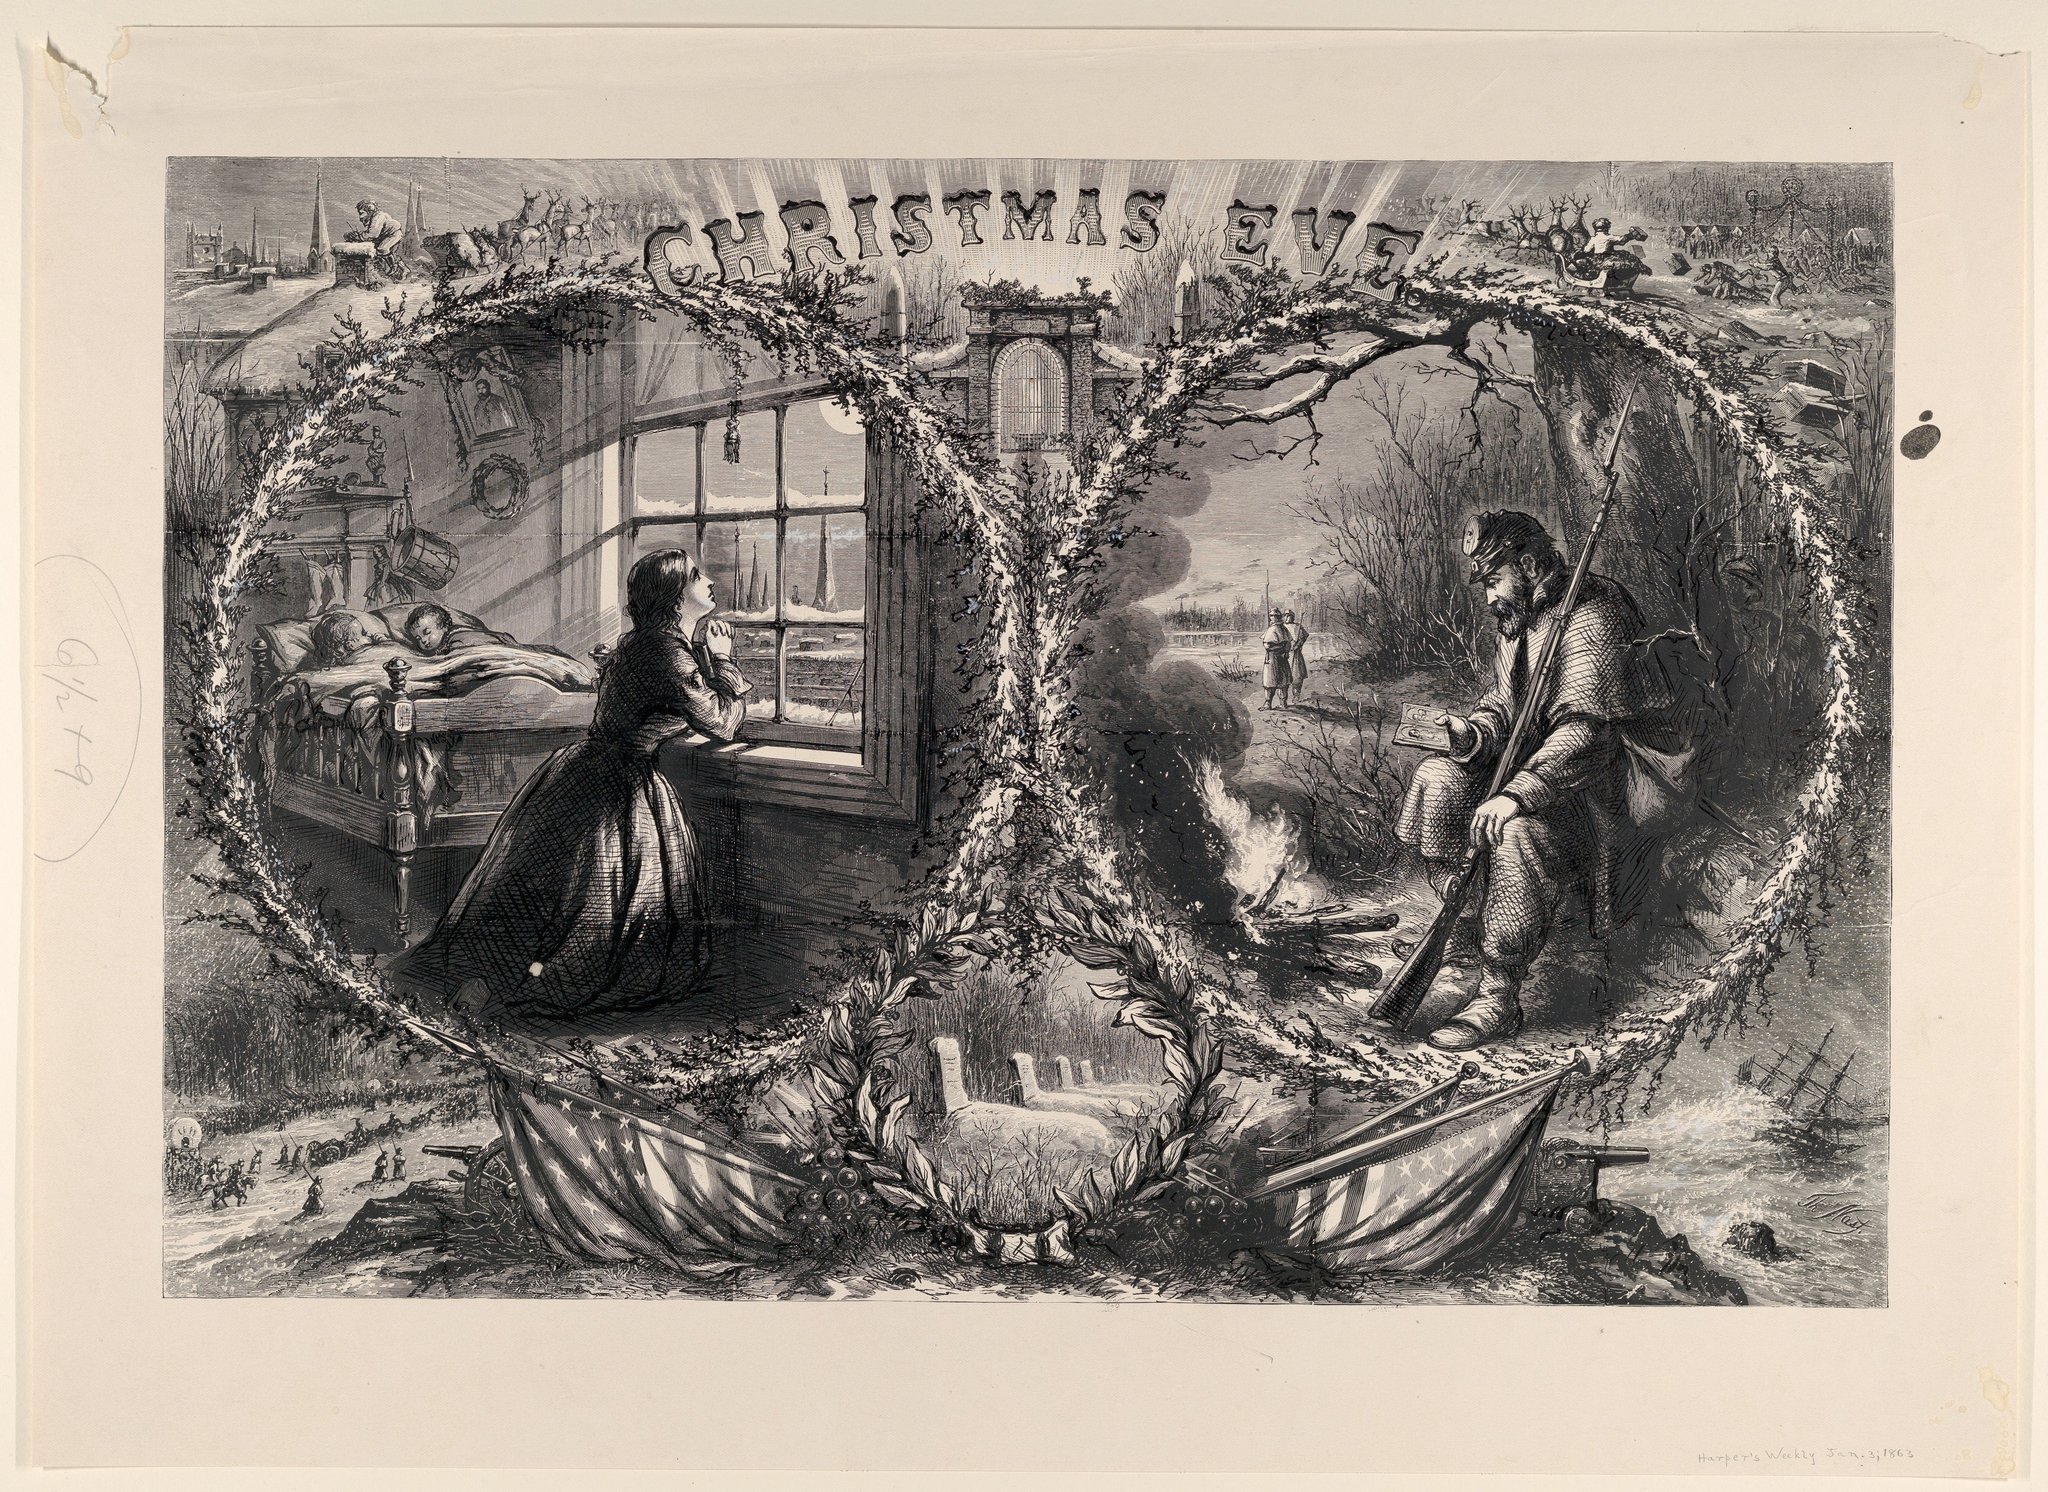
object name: print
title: Christmas Eve (published "Harper's Weekly," January 3, 1863)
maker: thomas nast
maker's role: artist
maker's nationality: american, born germany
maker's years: 1840-1902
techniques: relief print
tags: soldiers,american civil war,sleeping,children,men,women,christmas